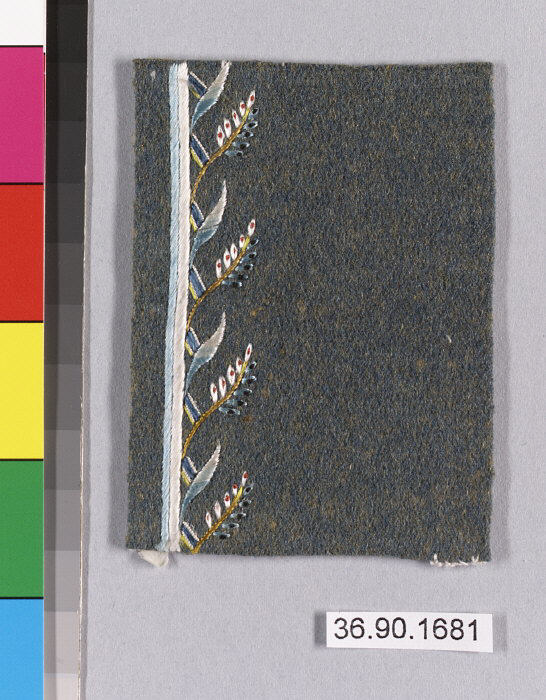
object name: sample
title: Embroidery sample for a man’s suit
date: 1785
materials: silk, wool